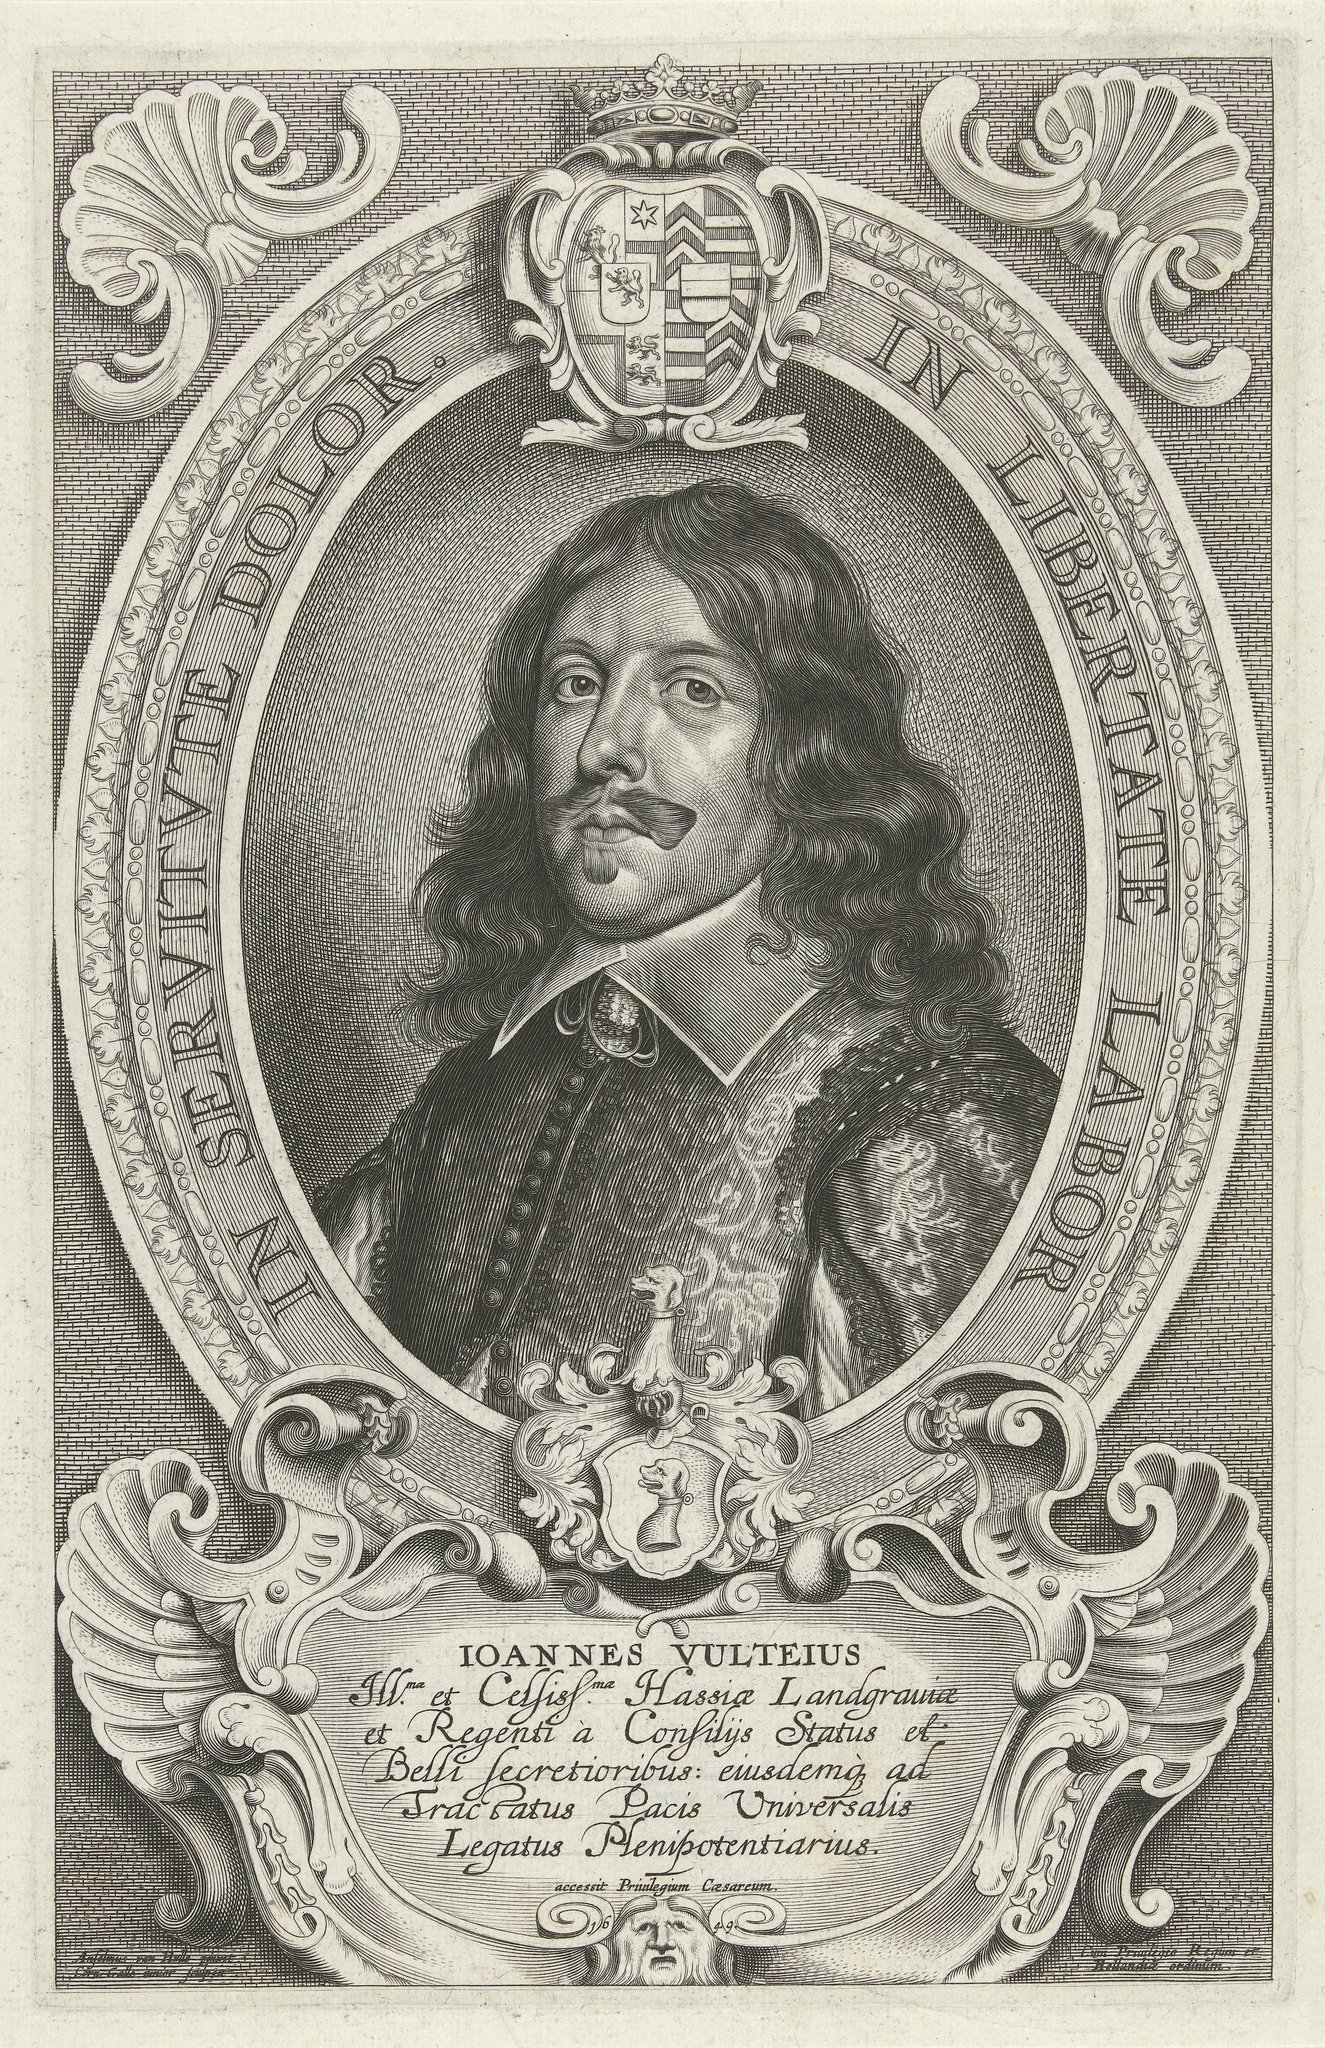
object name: print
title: Celeberrimi ad pacificandum Christiani nominis orbem legati Monasterium et Osnabrugas (...)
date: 1649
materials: paper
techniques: engraving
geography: antwerp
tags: marburg, kassel, jurist, afgezant, kanselier, johann vultejus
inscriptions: collector's mark: Lugt 2228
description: Portret van Johann Vultejus, afgezant voor de gravin Amalia Elisabeth van Hessen tijdens de onderhandelingen voor de Vrede van Münster. Portret in ovaal met motto. Onder het portret het familiewapen van Vultejus, boven het wapen van Hessen.